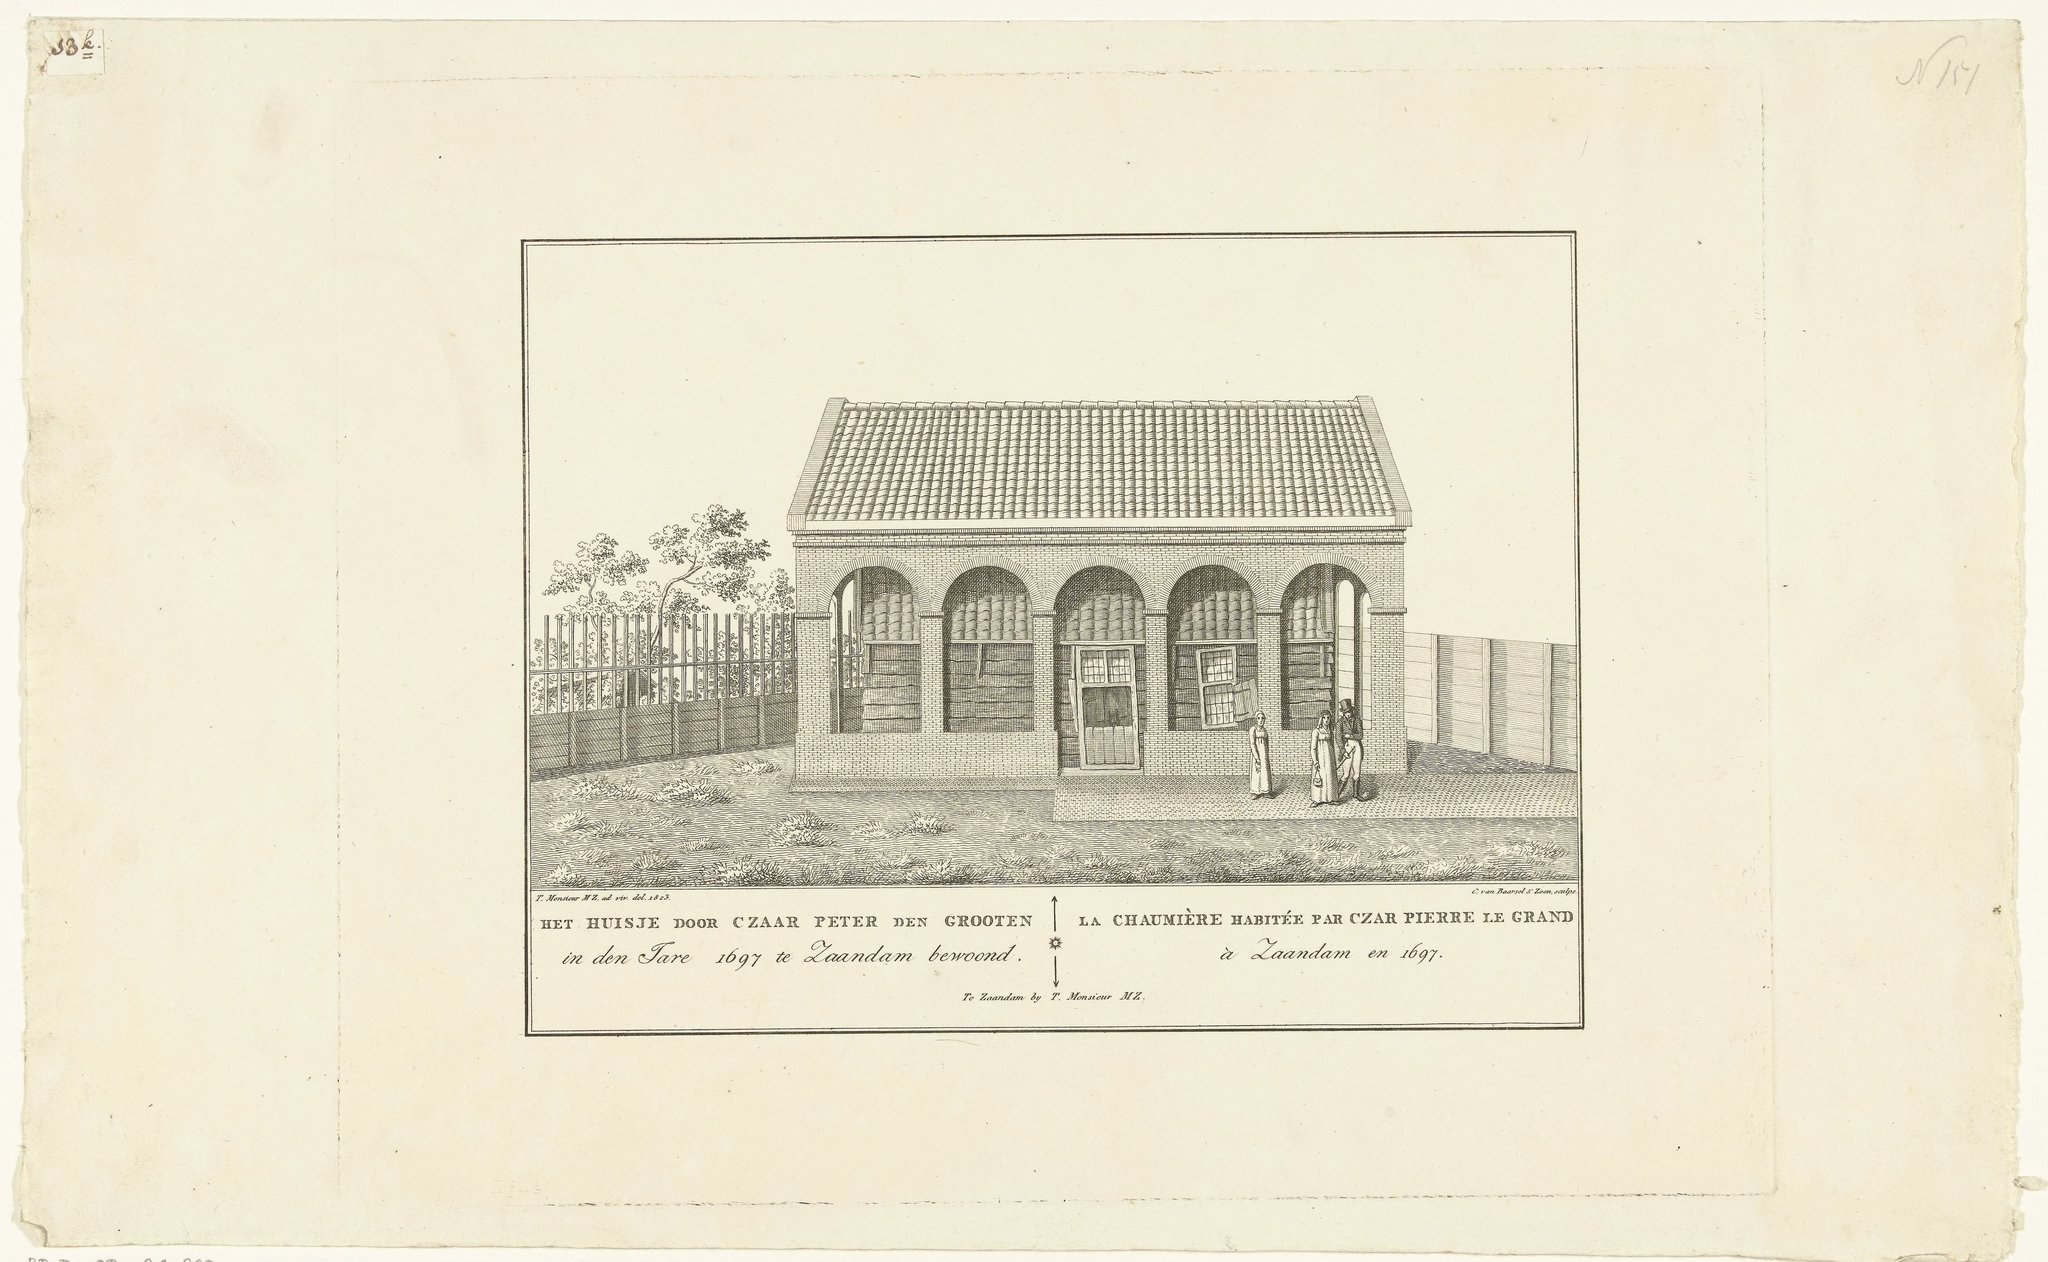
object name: print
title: Het huisje door czaar Peter den Grooten in den jare 1697 te Zaandam bewoond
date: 1823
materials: paper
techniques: etching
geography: zaandam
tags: peter i de grote (tsaar van rusland), rural housing, e.g. country-house, villa, cottage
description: Gezicht op een eenvoudig houten huis, eromheen is een stenen galerij met dak ter bescherming geplaatst. Voor het huis drie bezoekers.